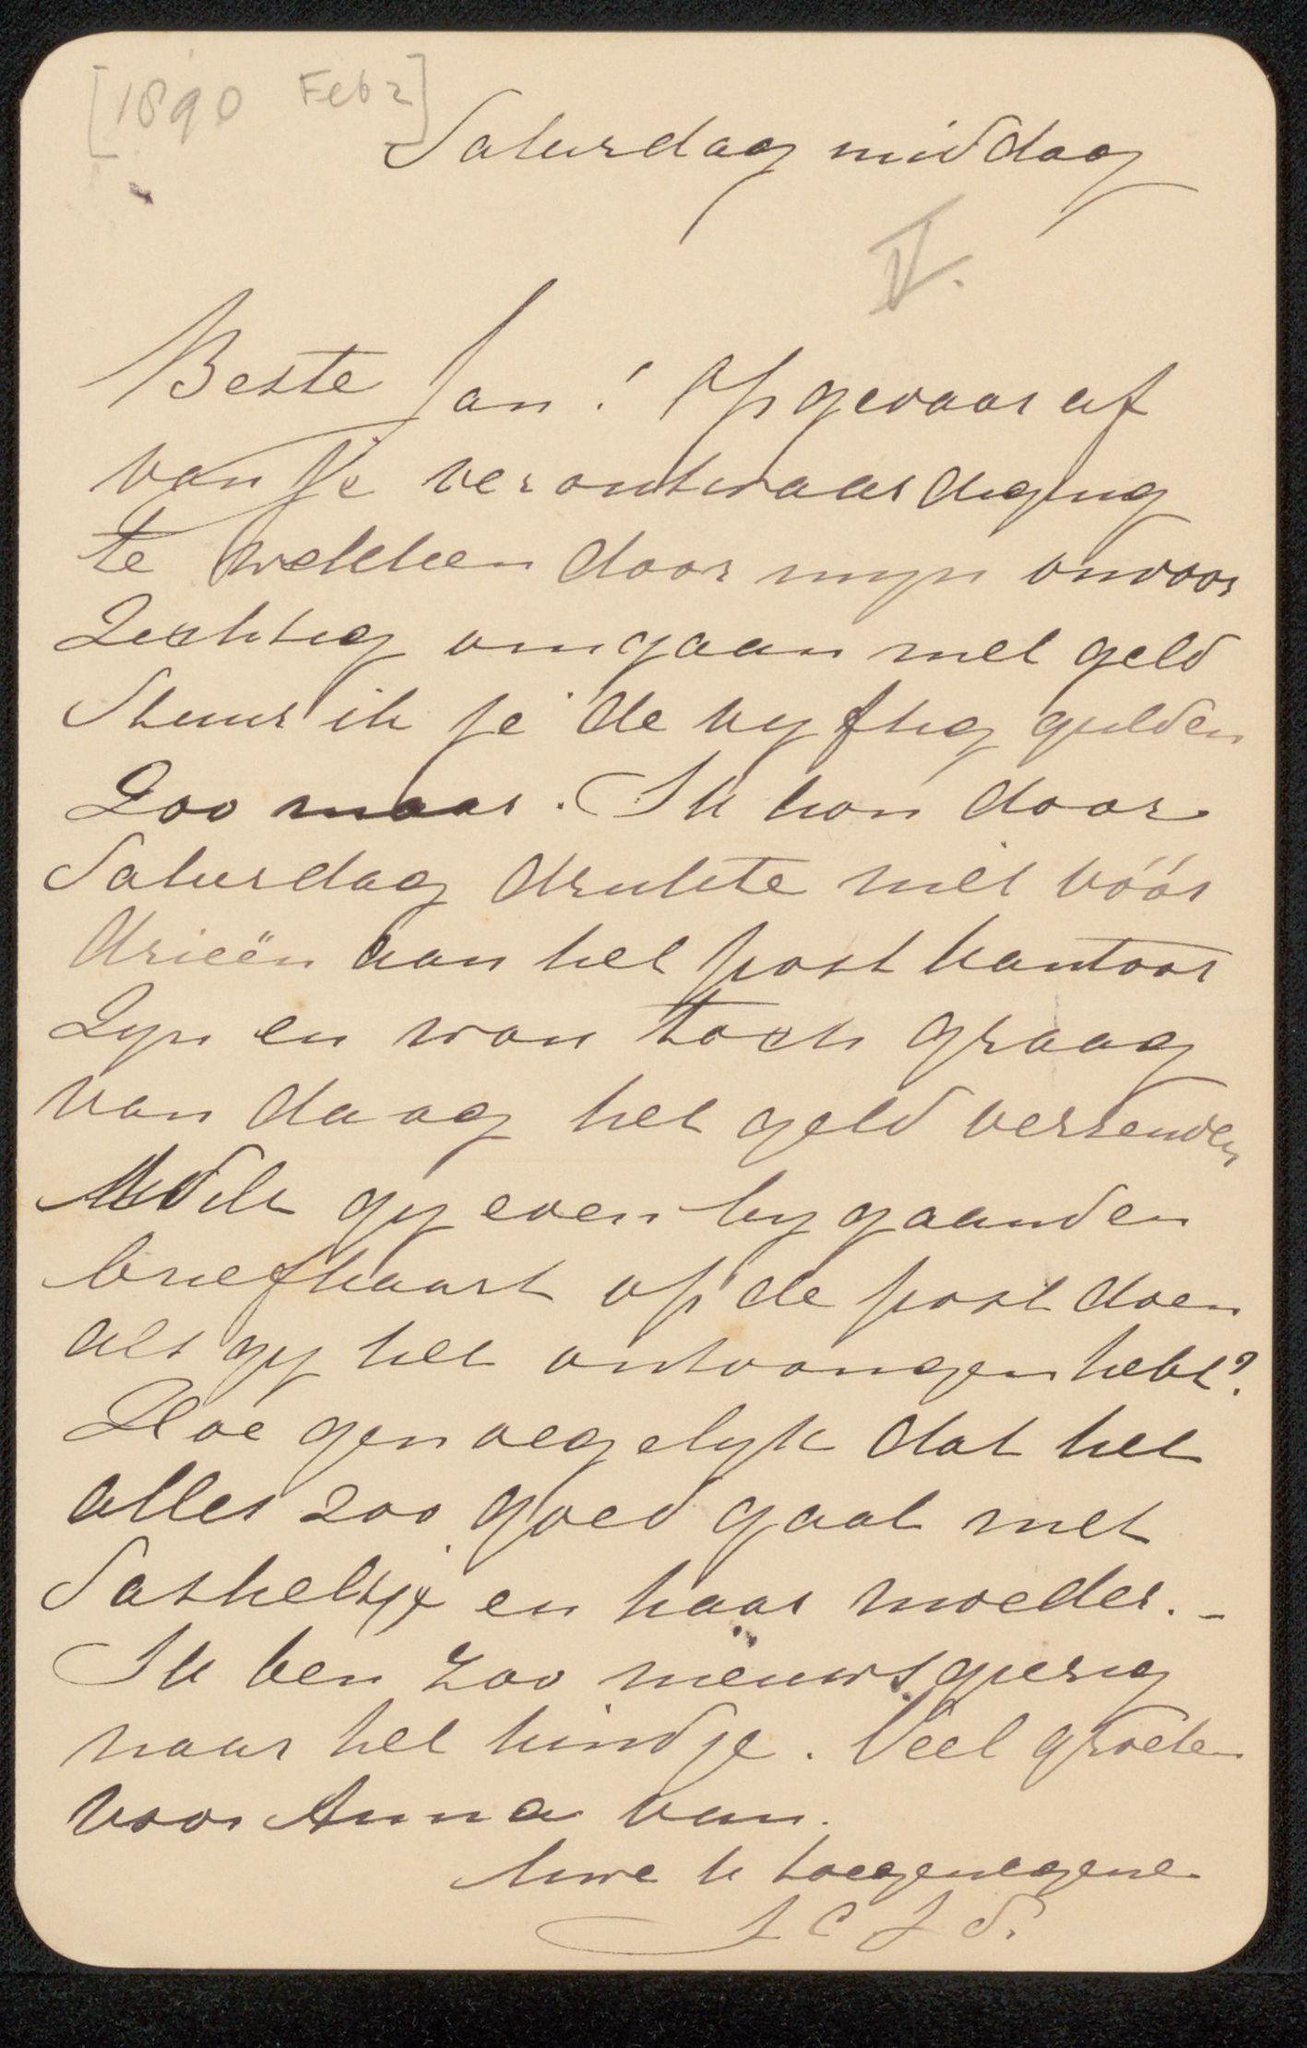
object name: letter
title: Brief aan Jan Veth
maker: jacoba cornelia jolles-singels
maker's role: schrijver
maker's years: 1847-1901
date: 1802-1890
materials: ink, paper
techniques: pen, writing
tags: painter, draughtsman, designer, jan veth, cornelia johanna veth, money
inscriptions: collector's mark: ‘RPK’